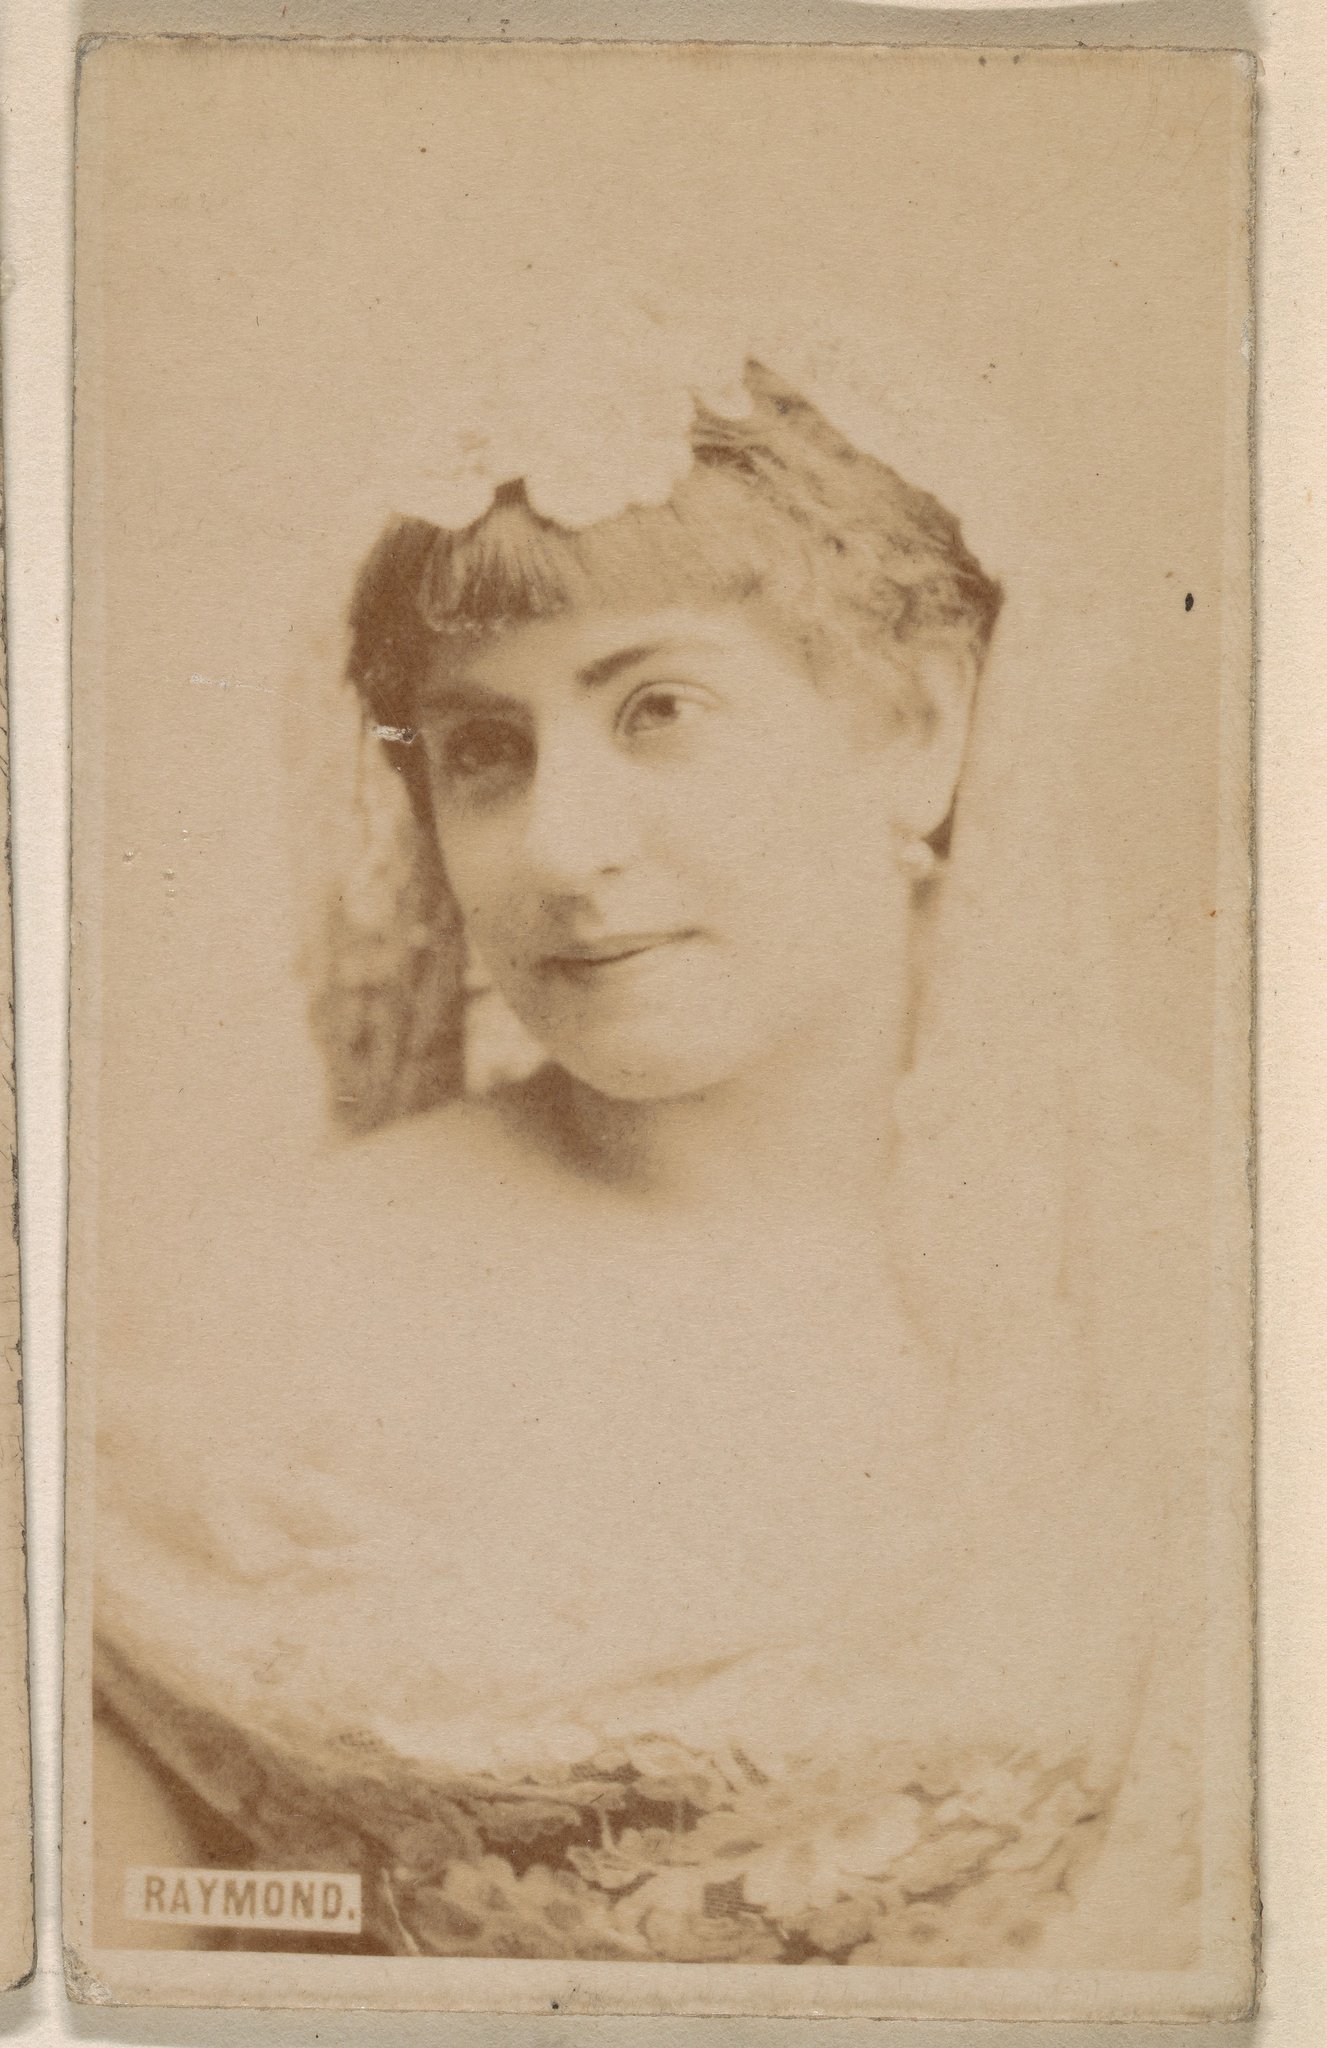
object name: photograph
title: Miss Raymond, from the Actresses series (N246), Type 1, issued by Kinney Brothers to promote Sporting Extra Cigarettes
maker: kinney brothers tobacco company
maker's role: publisher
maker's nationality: american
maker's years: 1869-2011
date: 1890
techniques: albumen silver print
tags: portraits,women,actresses